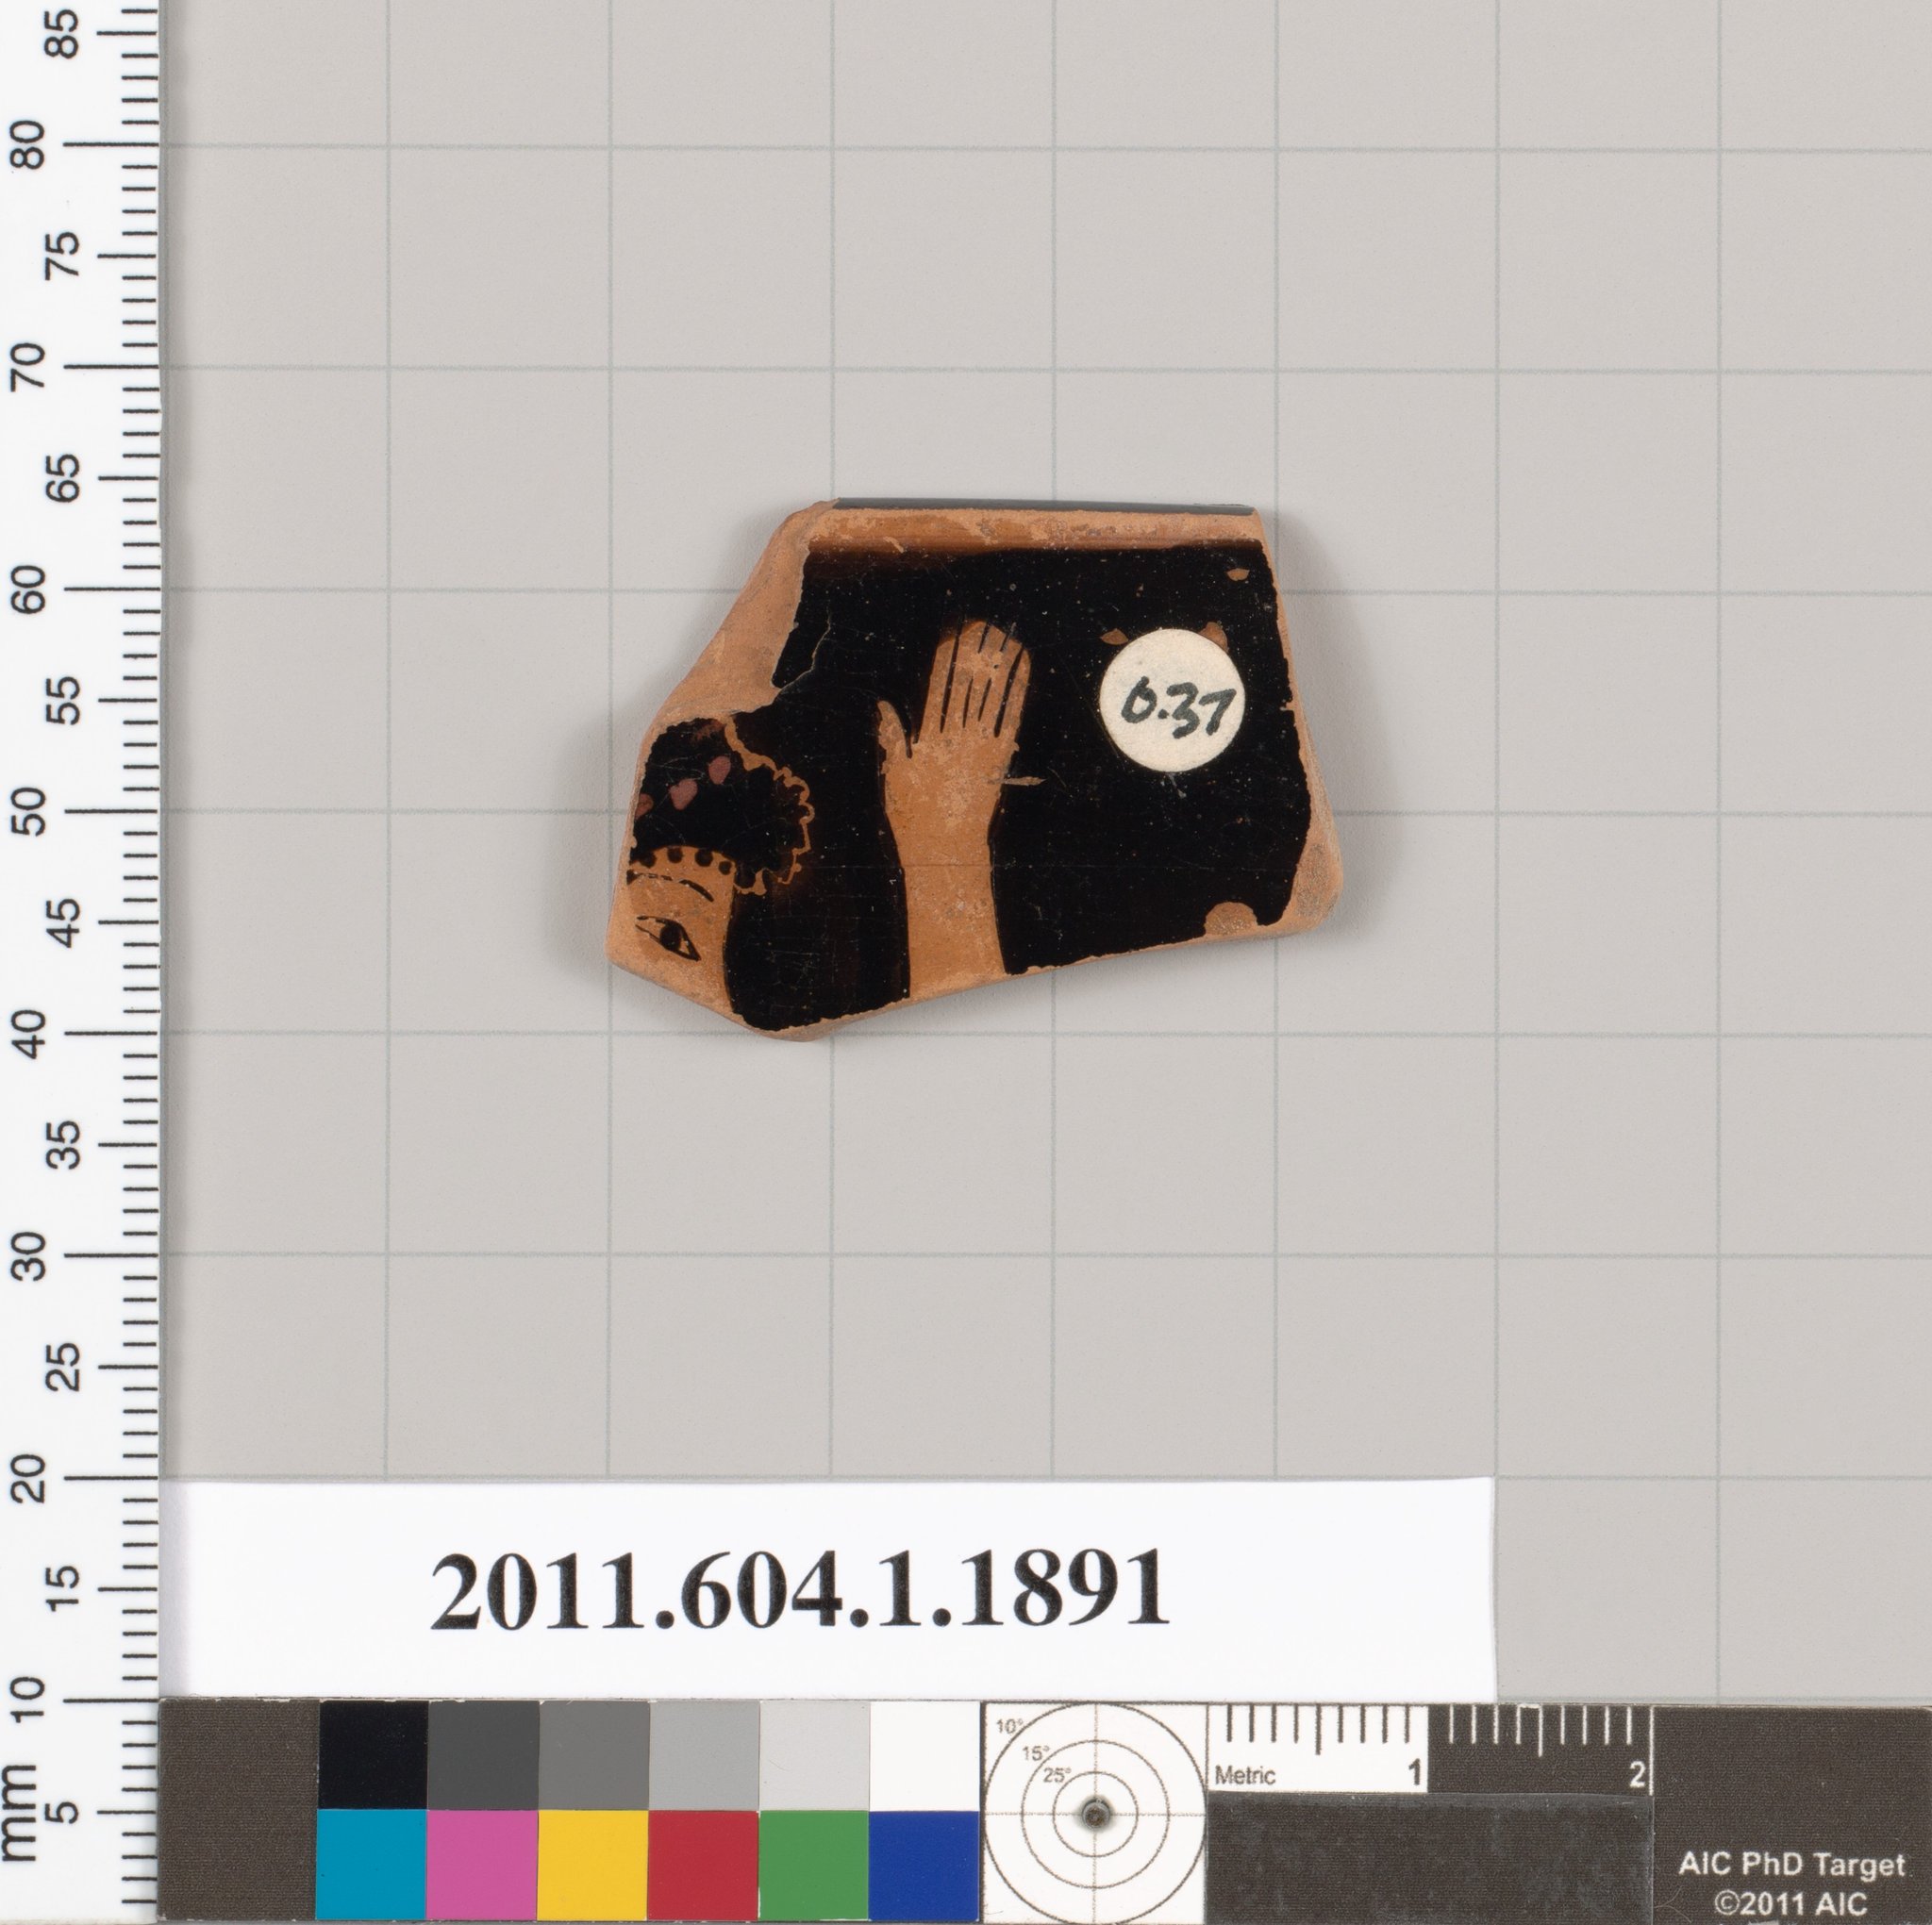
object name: kylix fragment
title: Terracotta rim fragment of a kylix (drinking cup)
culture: greek, attic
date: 520-510 BCE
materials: terracotta